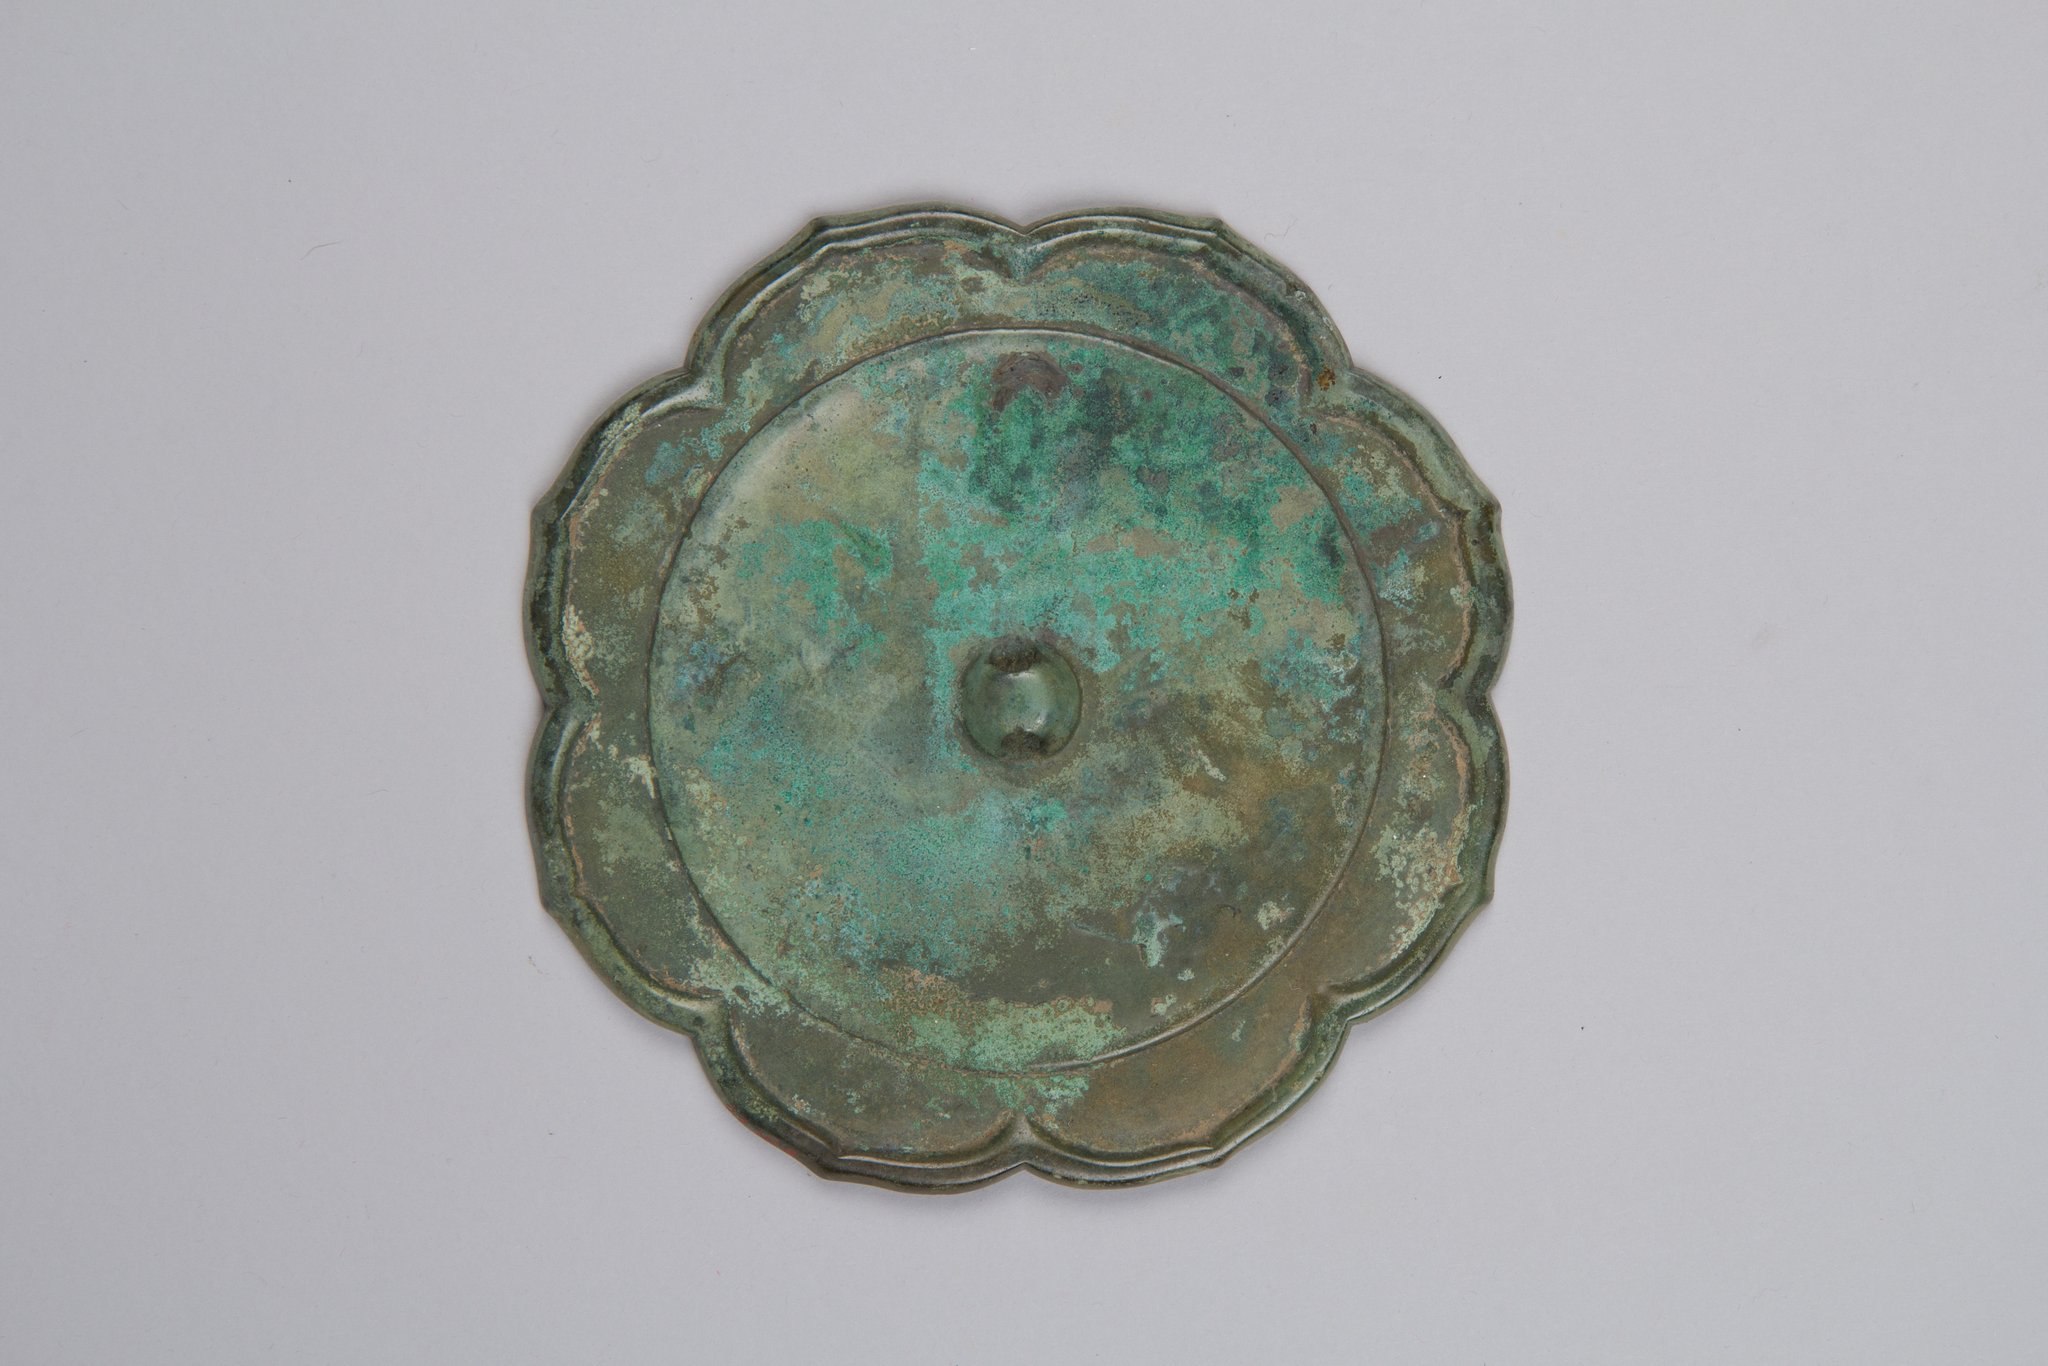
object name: mirror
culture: korean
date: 918-1392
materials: bronze